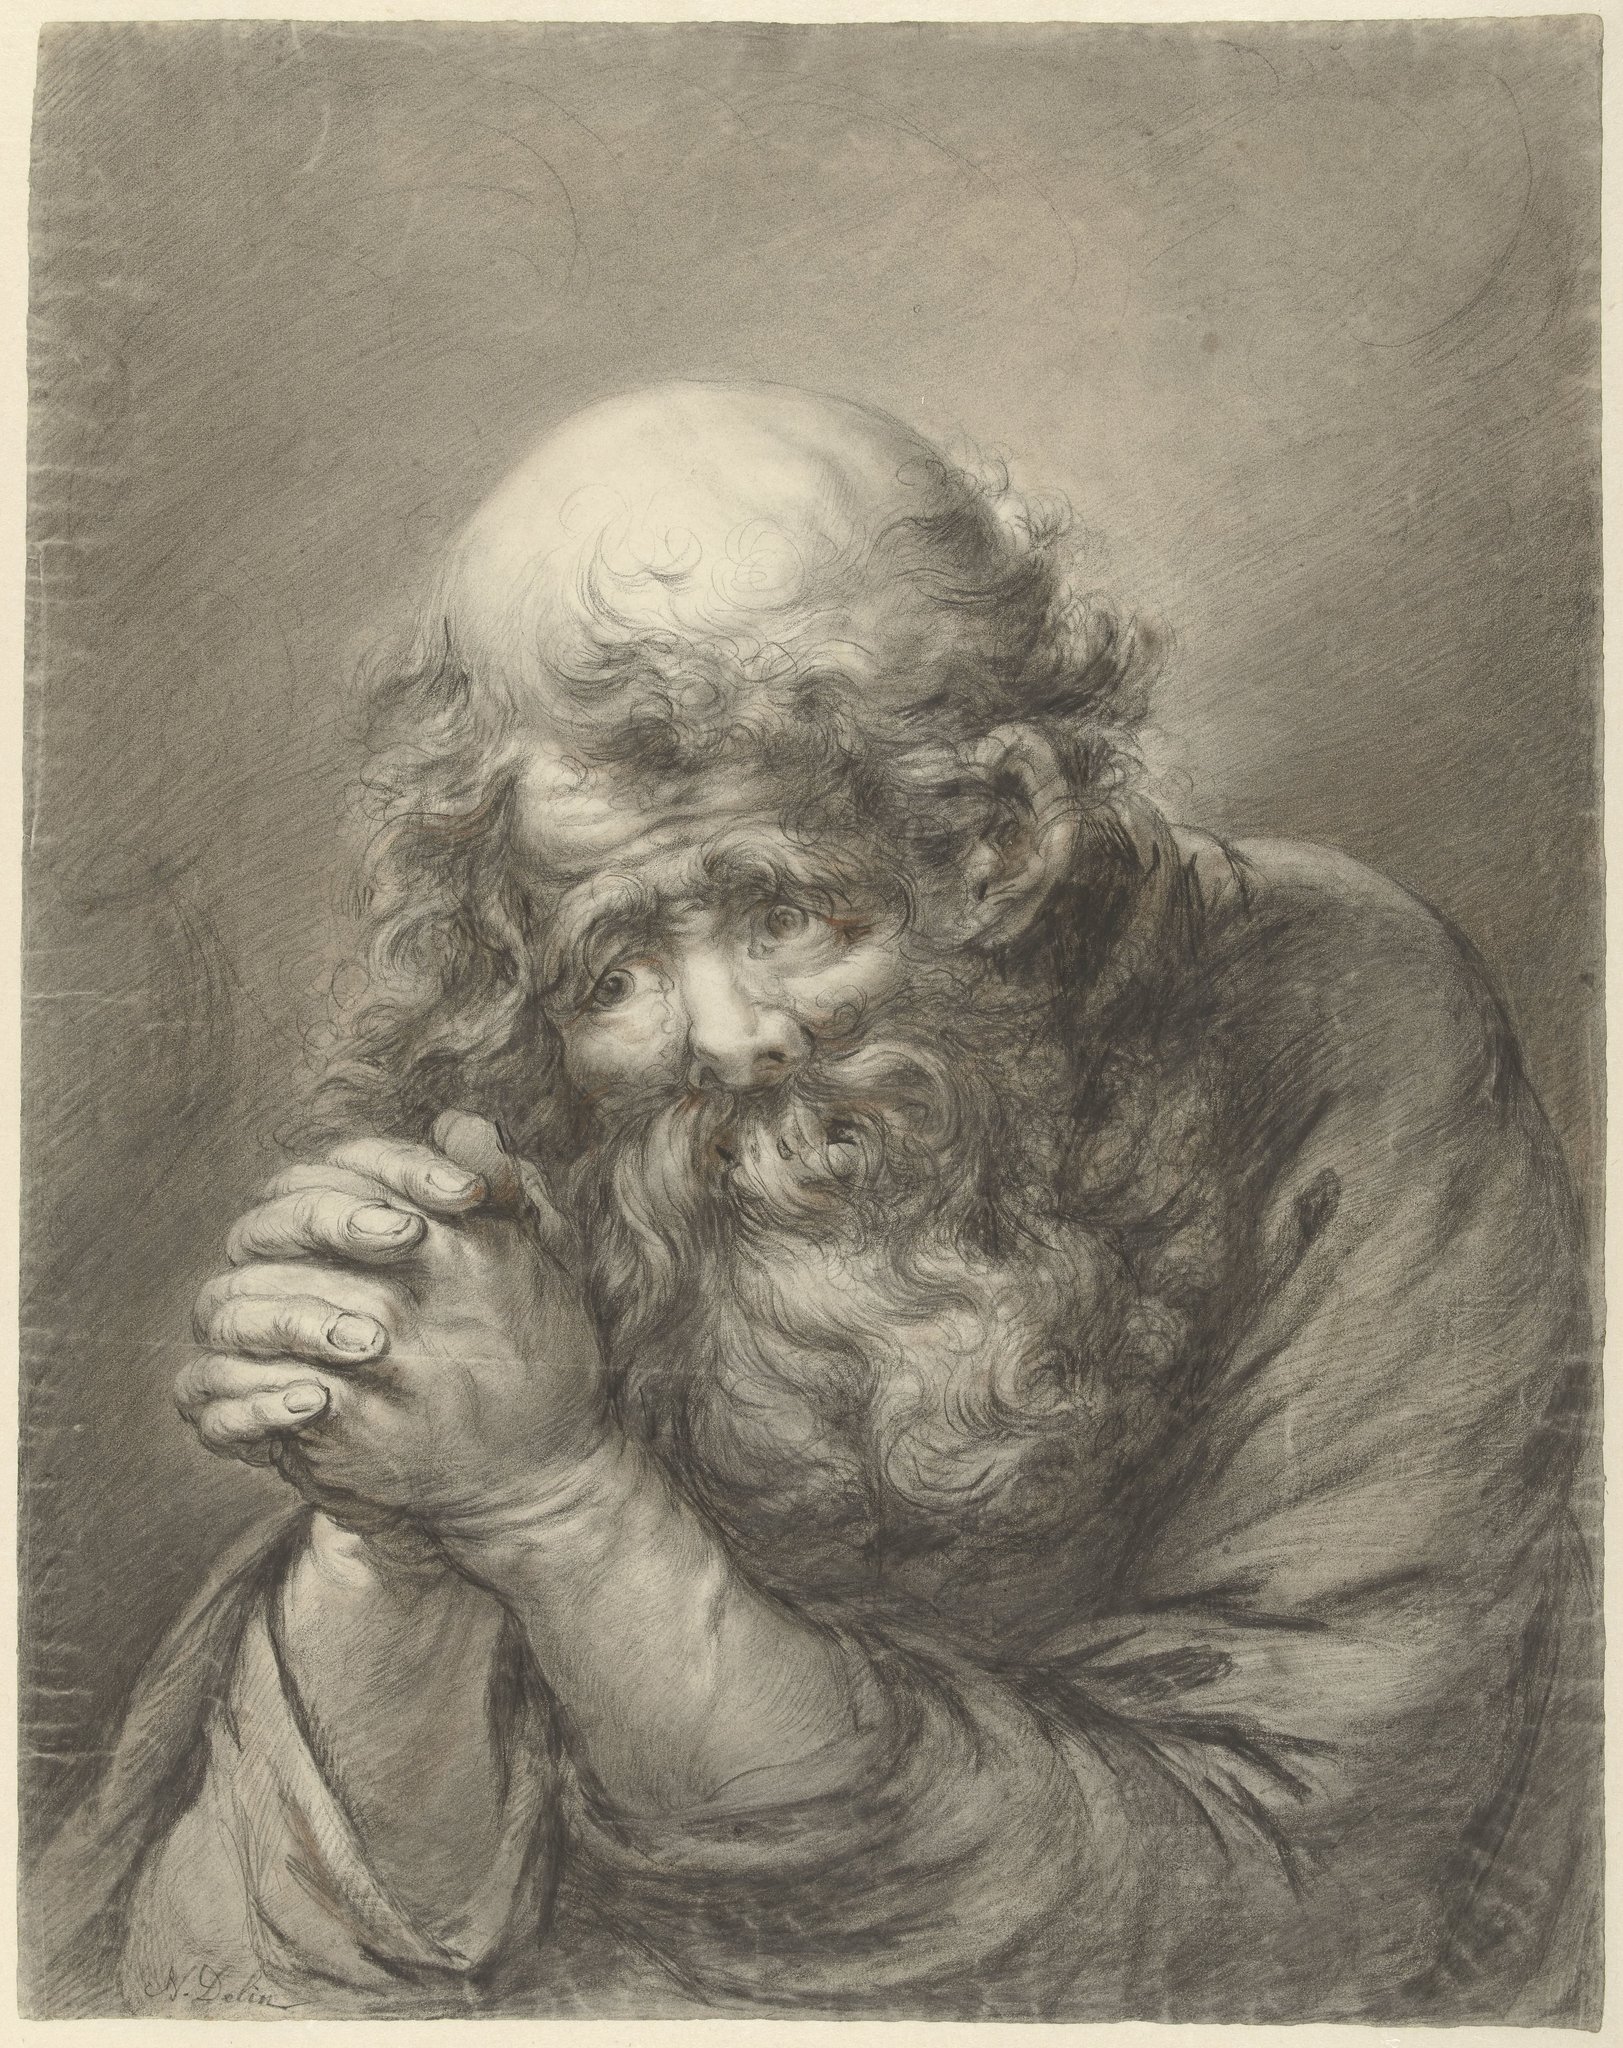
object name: drawing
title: Oude man met baard met gevouwen handen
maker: nicolas joseph delin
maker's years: 1741-1803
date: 1751-1803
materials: chalk, paper